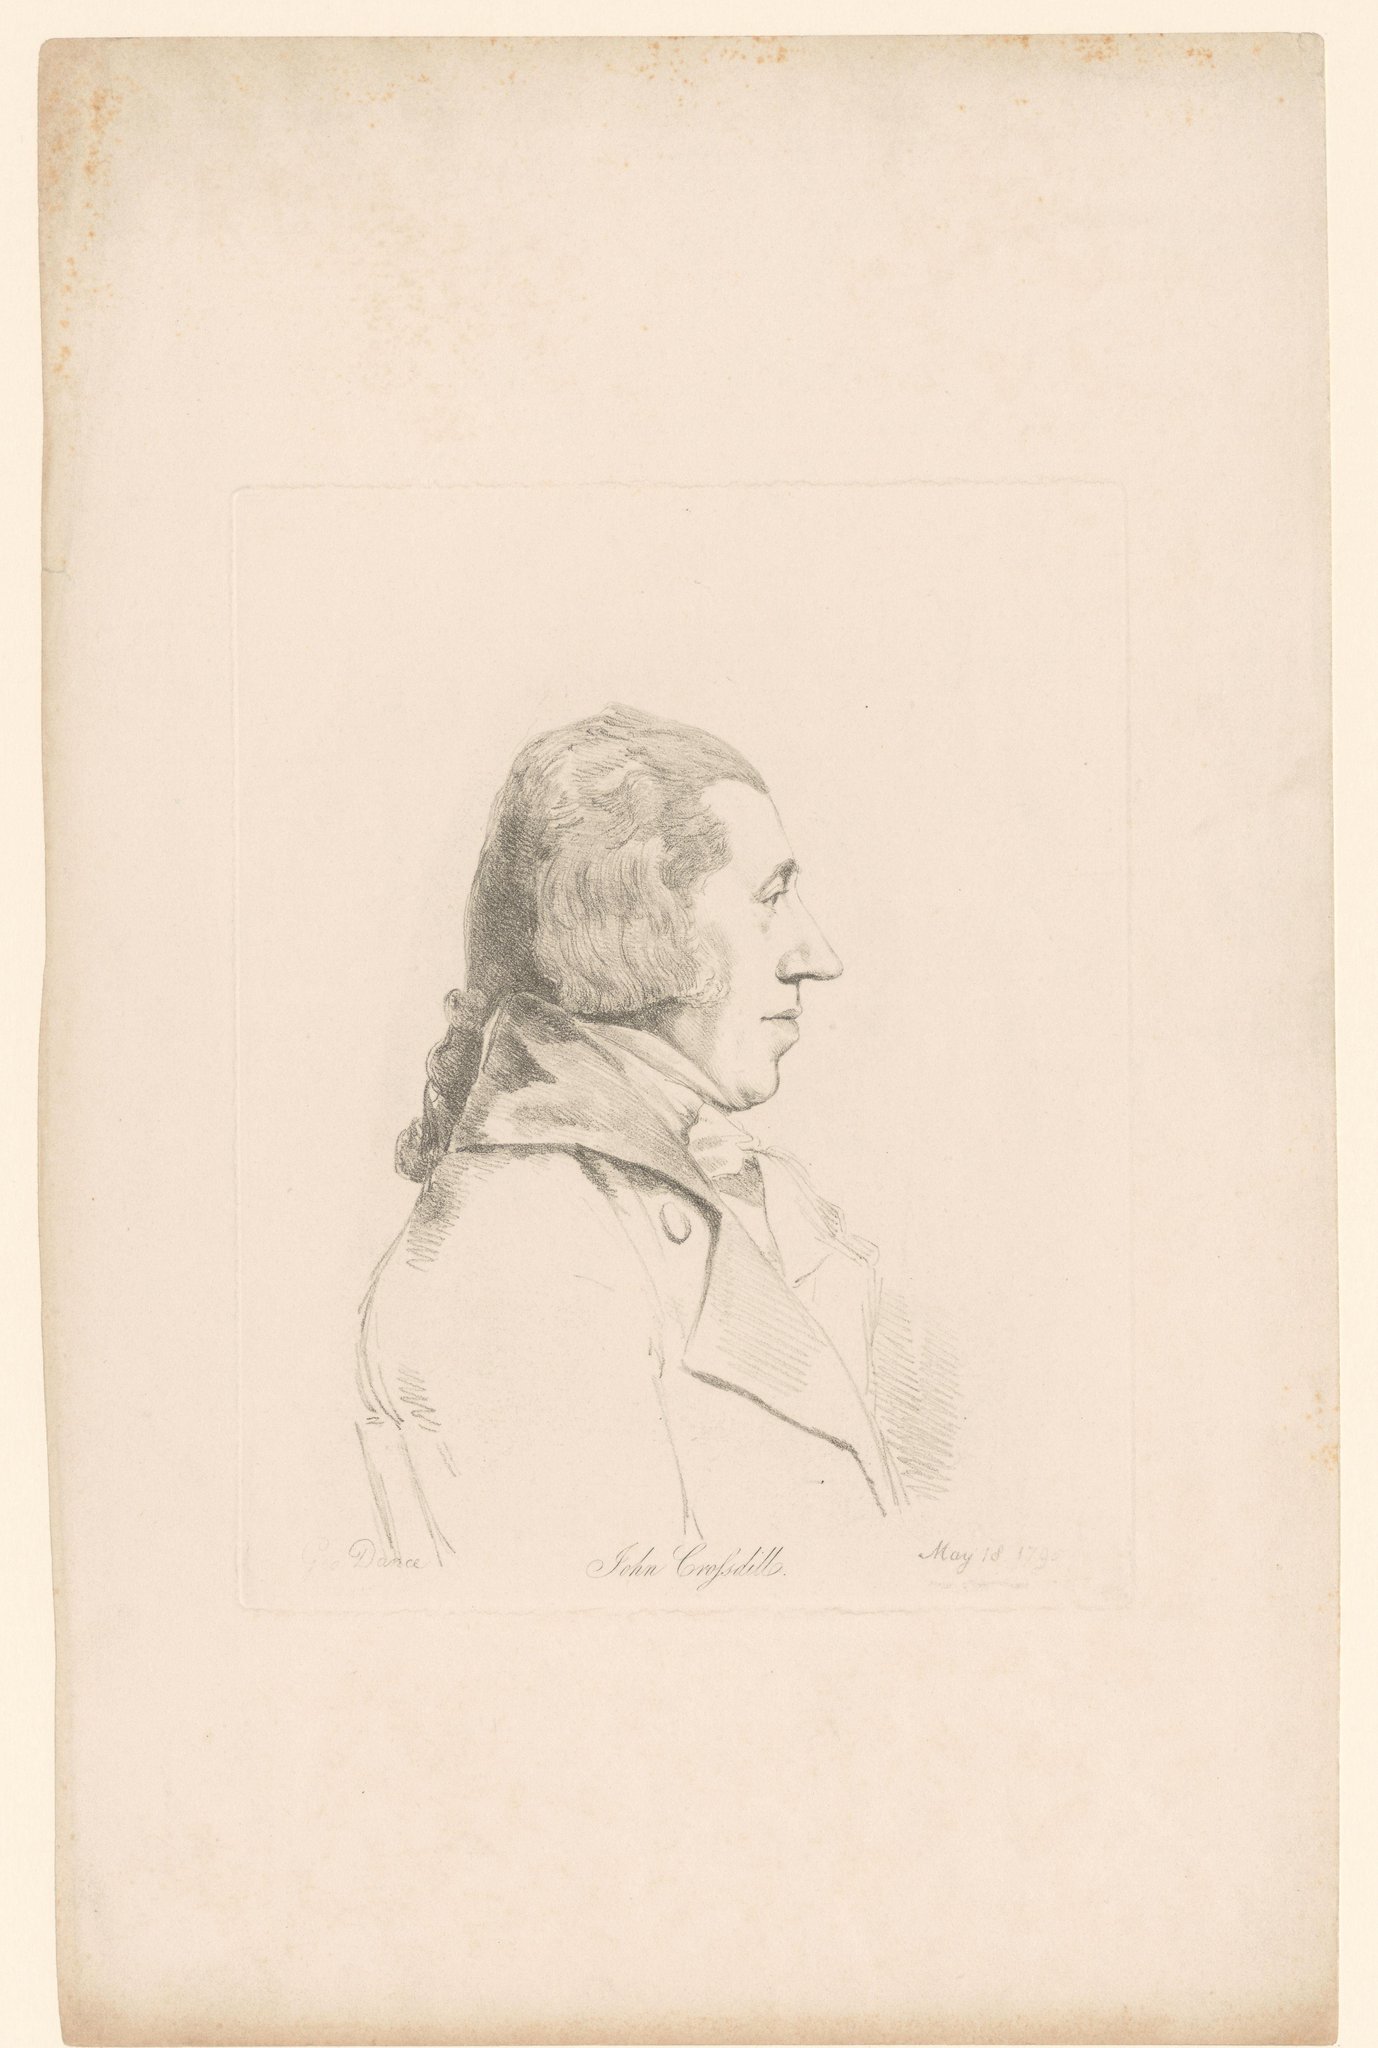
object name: print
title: Portret van John Crosdill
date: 1795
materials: paper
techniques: printmaking, etching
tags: london, musician, historical persons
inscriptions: collector's mark: Lugt 2228